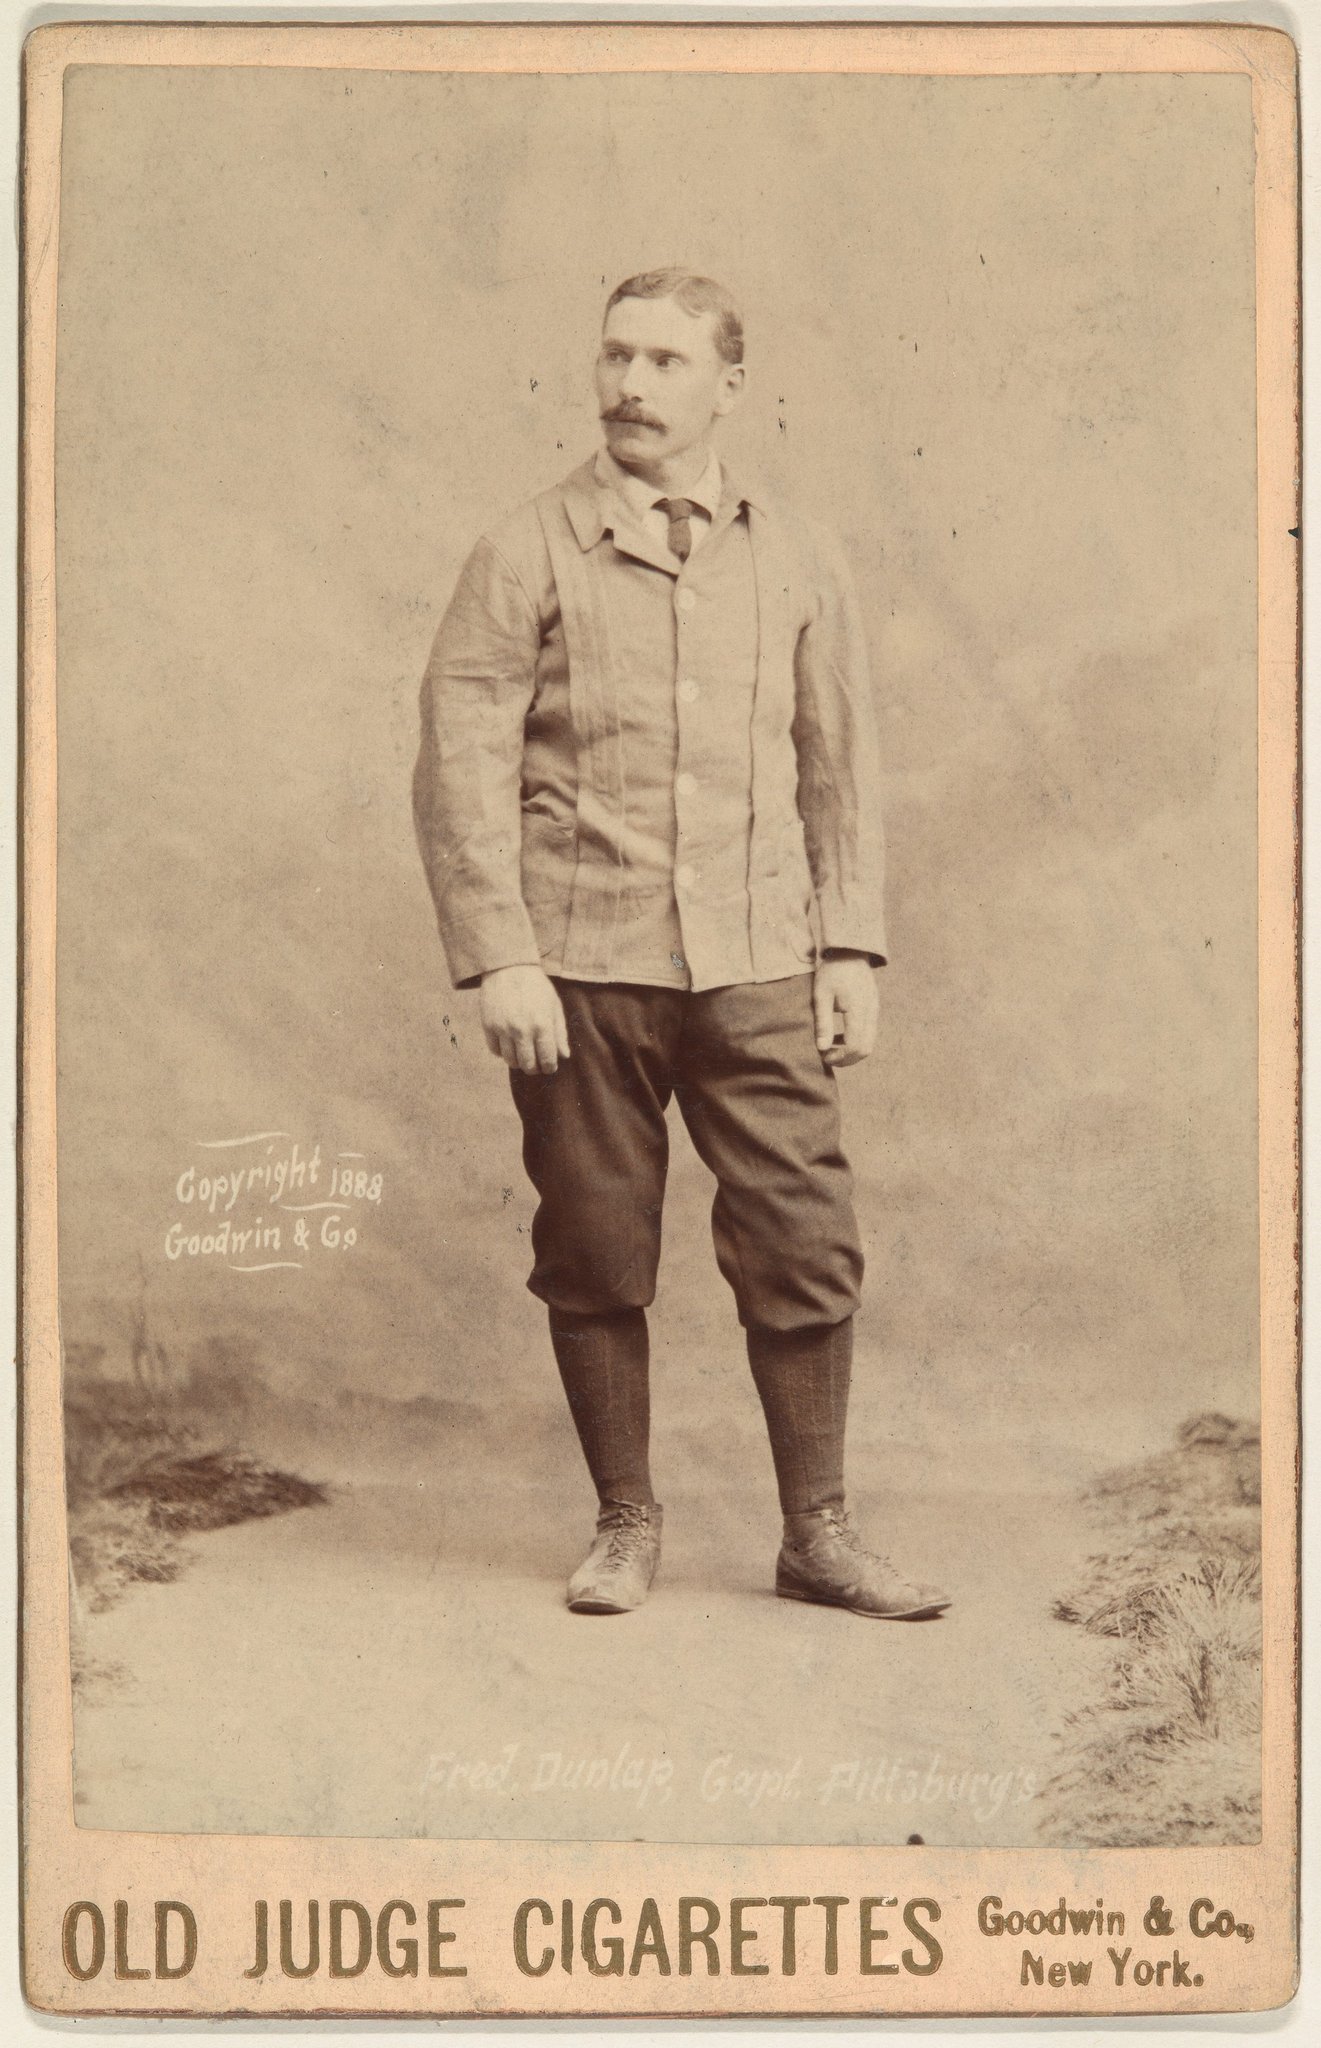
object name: baseball card, photograph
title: Fred C. Dunlap, Captain, Pittsburgh, from the series Old Judge Cigarettes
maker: goodwin & company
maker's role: publisher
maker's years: 1850-1950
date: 1888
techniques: albumen print, photography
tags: men,portraits